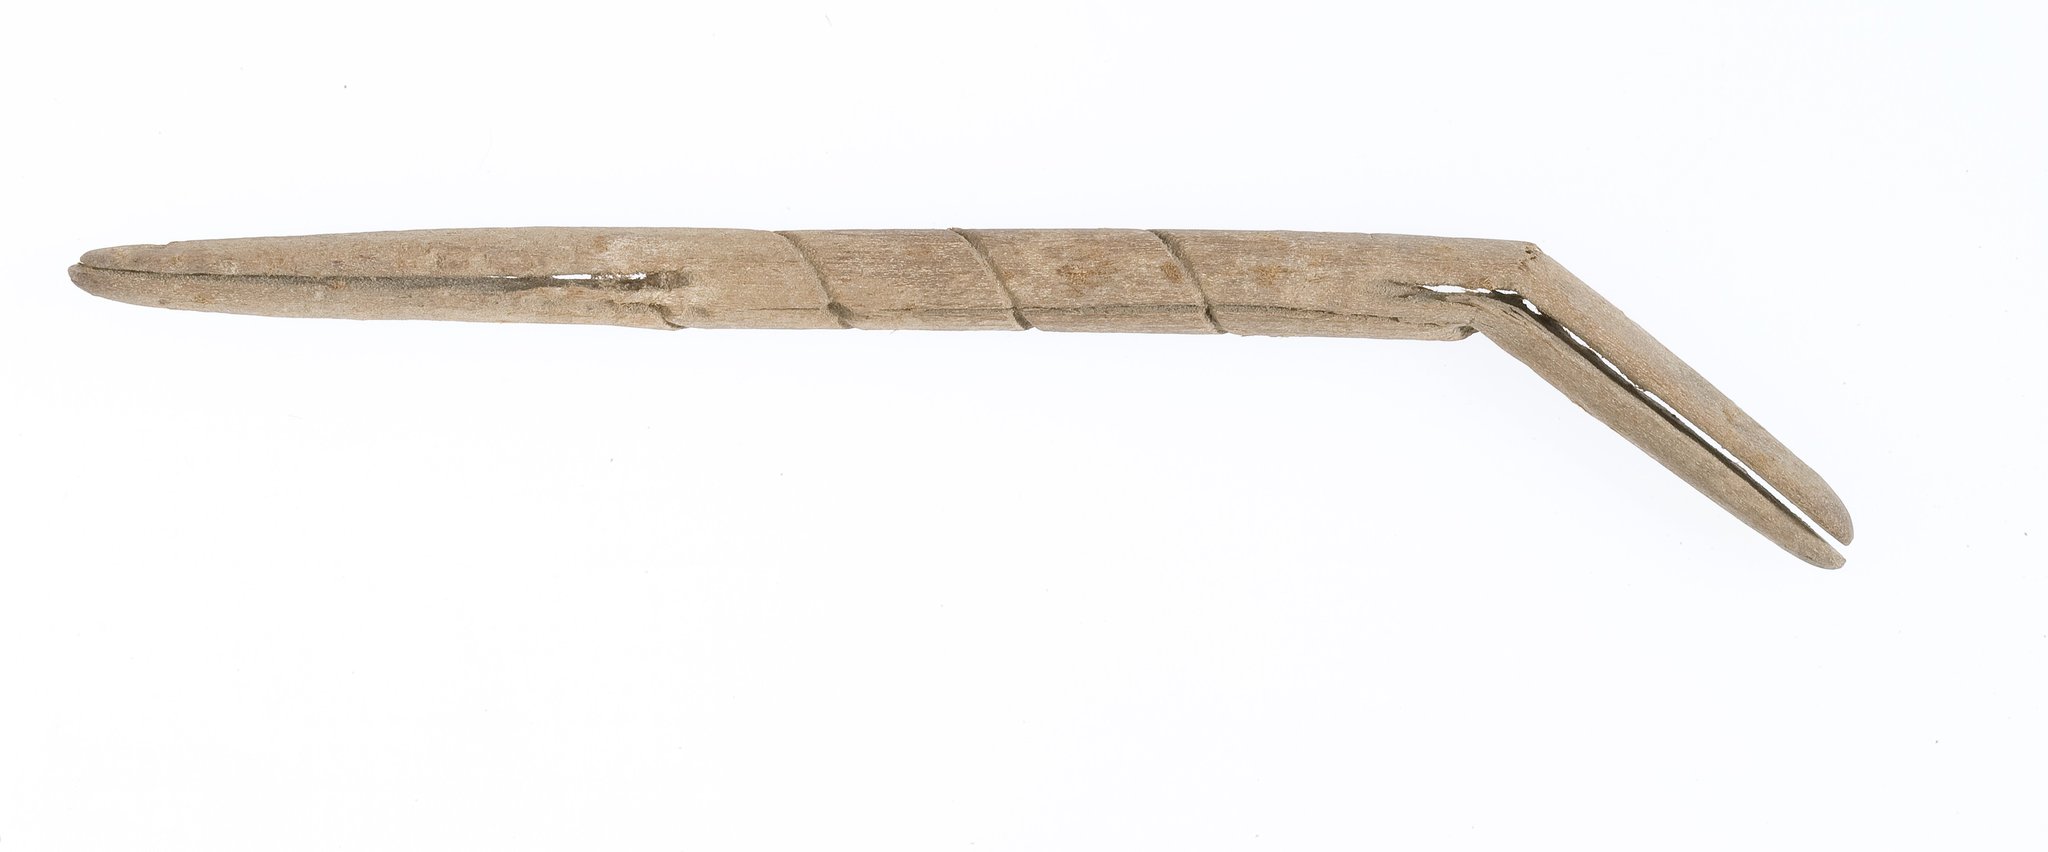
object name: spool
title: Weaving tool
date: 1295-1070 BCE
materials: wood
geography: egypt